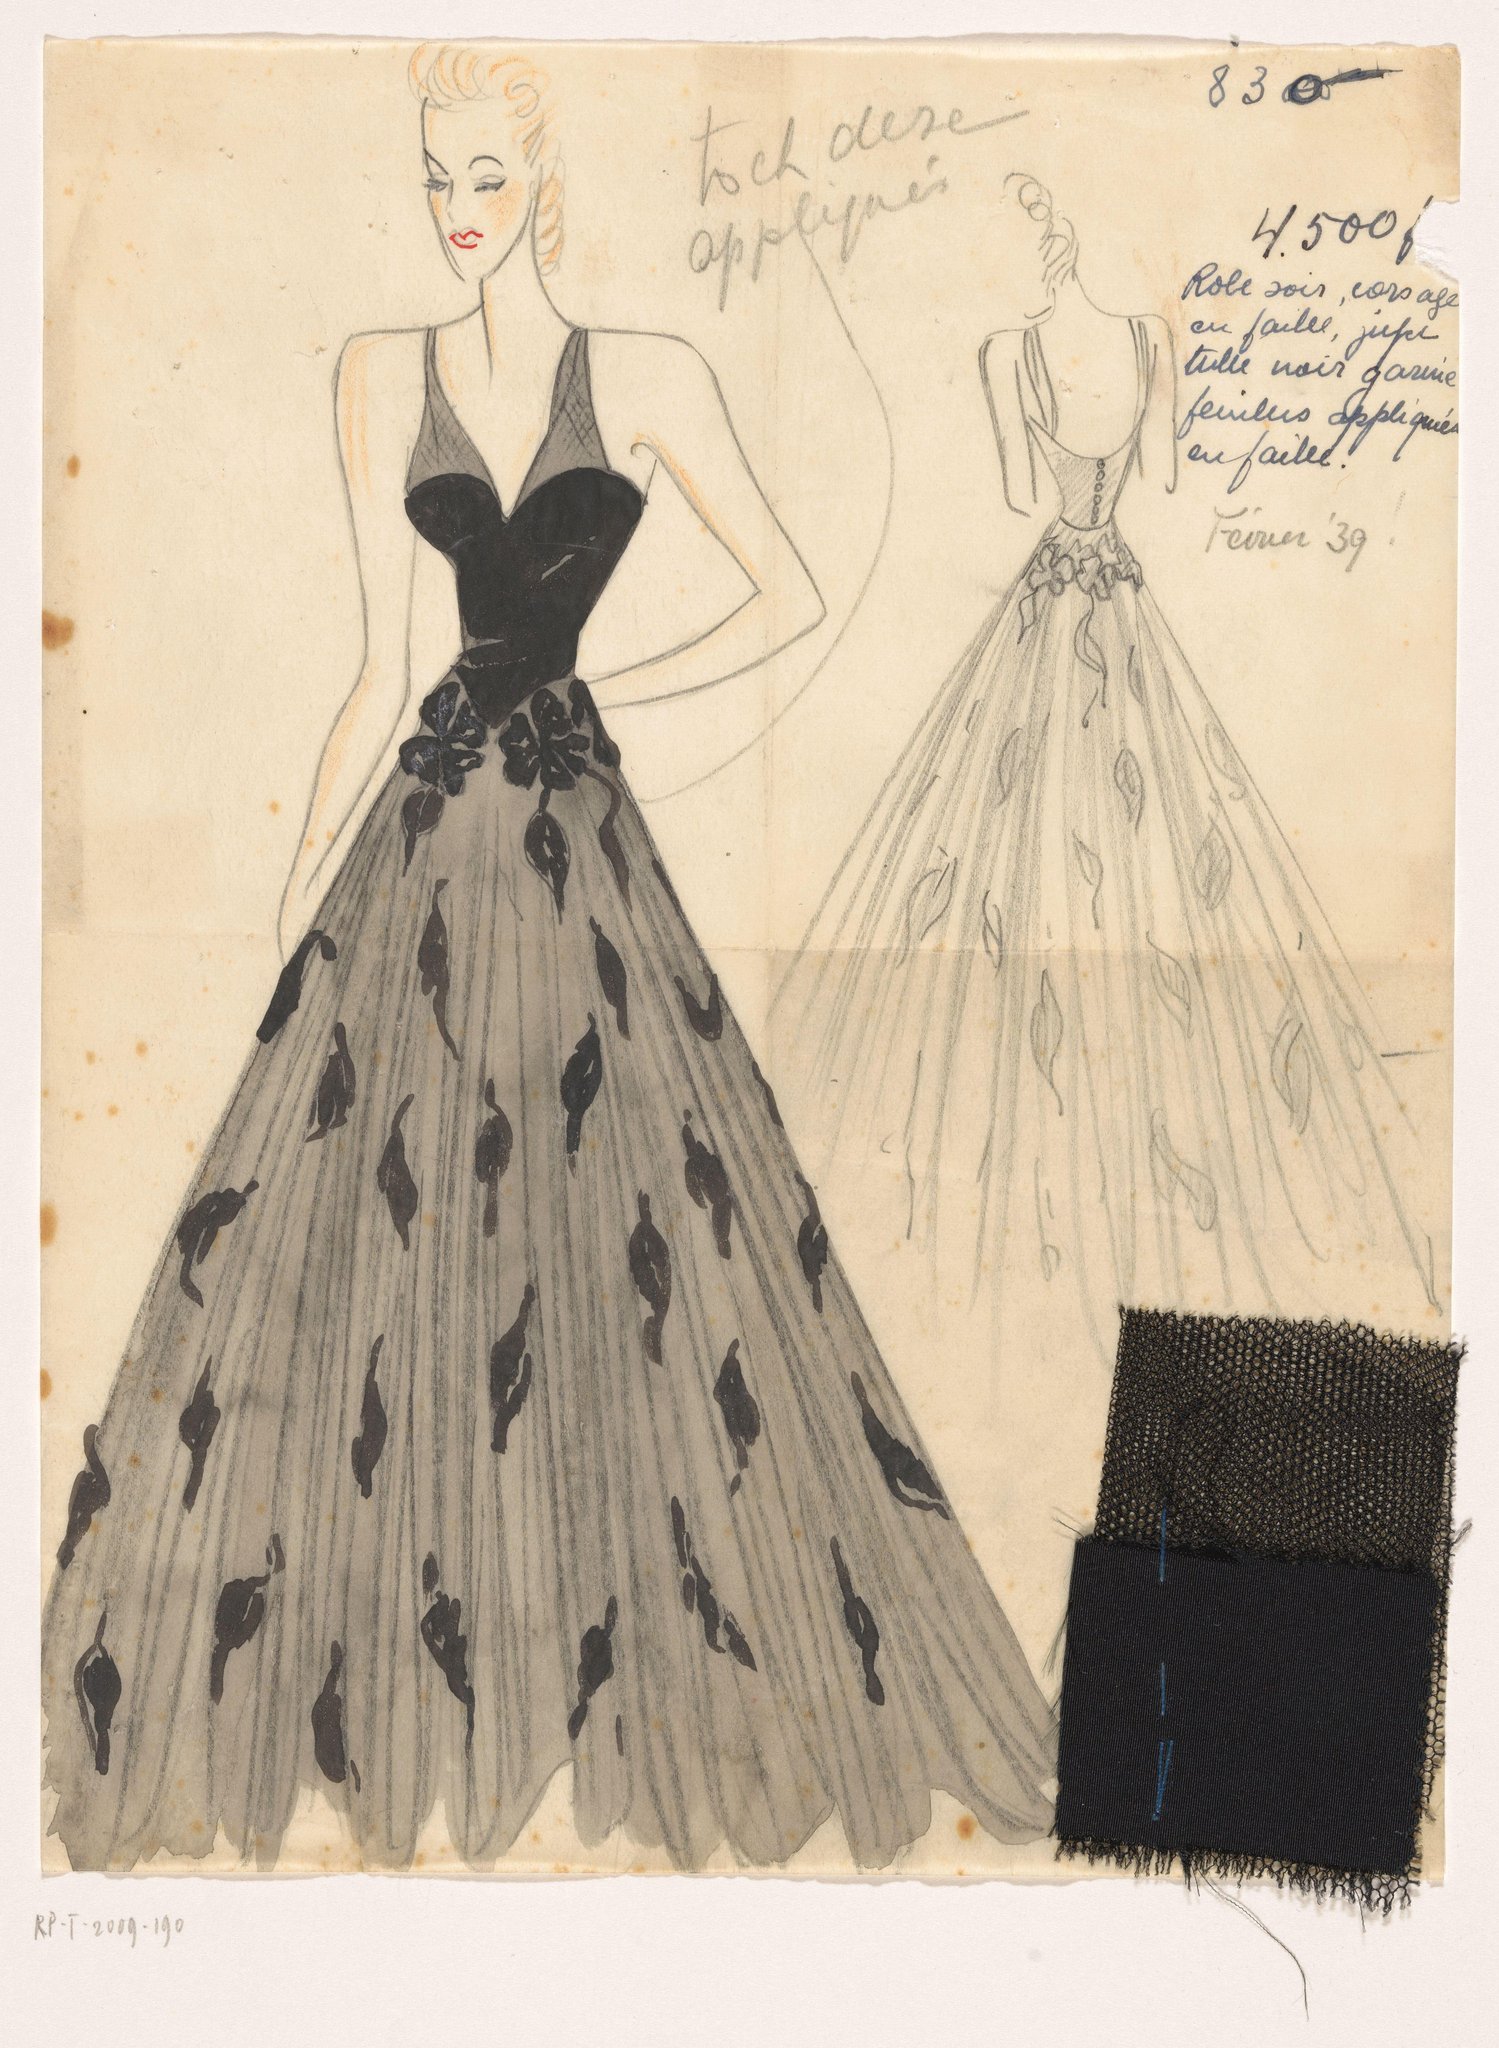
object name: fashion plate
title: Robe soir, corsage en faille, jupe tulle noir garnie feuilles appliqués en faille.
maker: jean dessès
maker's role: modeontwerper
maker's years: 1904-1970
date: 1939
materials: paper, pencil, watercolor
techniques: brush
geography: paris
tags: dress, gown (afternoon dress) (+ women's clothes), fashion plates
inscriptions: number: ‘830’, title: ‘Robe soir, corsage en faille, jupe tulle noir garnie feuilles appliqués en faille. 4.500 frs.’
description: Avondjapon van zwarte faille met zwarte tule. Getailleerde bustier met diepe v-hals en blote rug. Lange, wijdvallende rok met geschulpte zoom. Ontwerp februari 1939. In de rechter benedenhoek een staaltje zwarte faille en een staaltje zwarte tule met helder blauw garen op het papier genaaid. Annotatie: toch deze appliqués. Prijs: 4.500 francs.